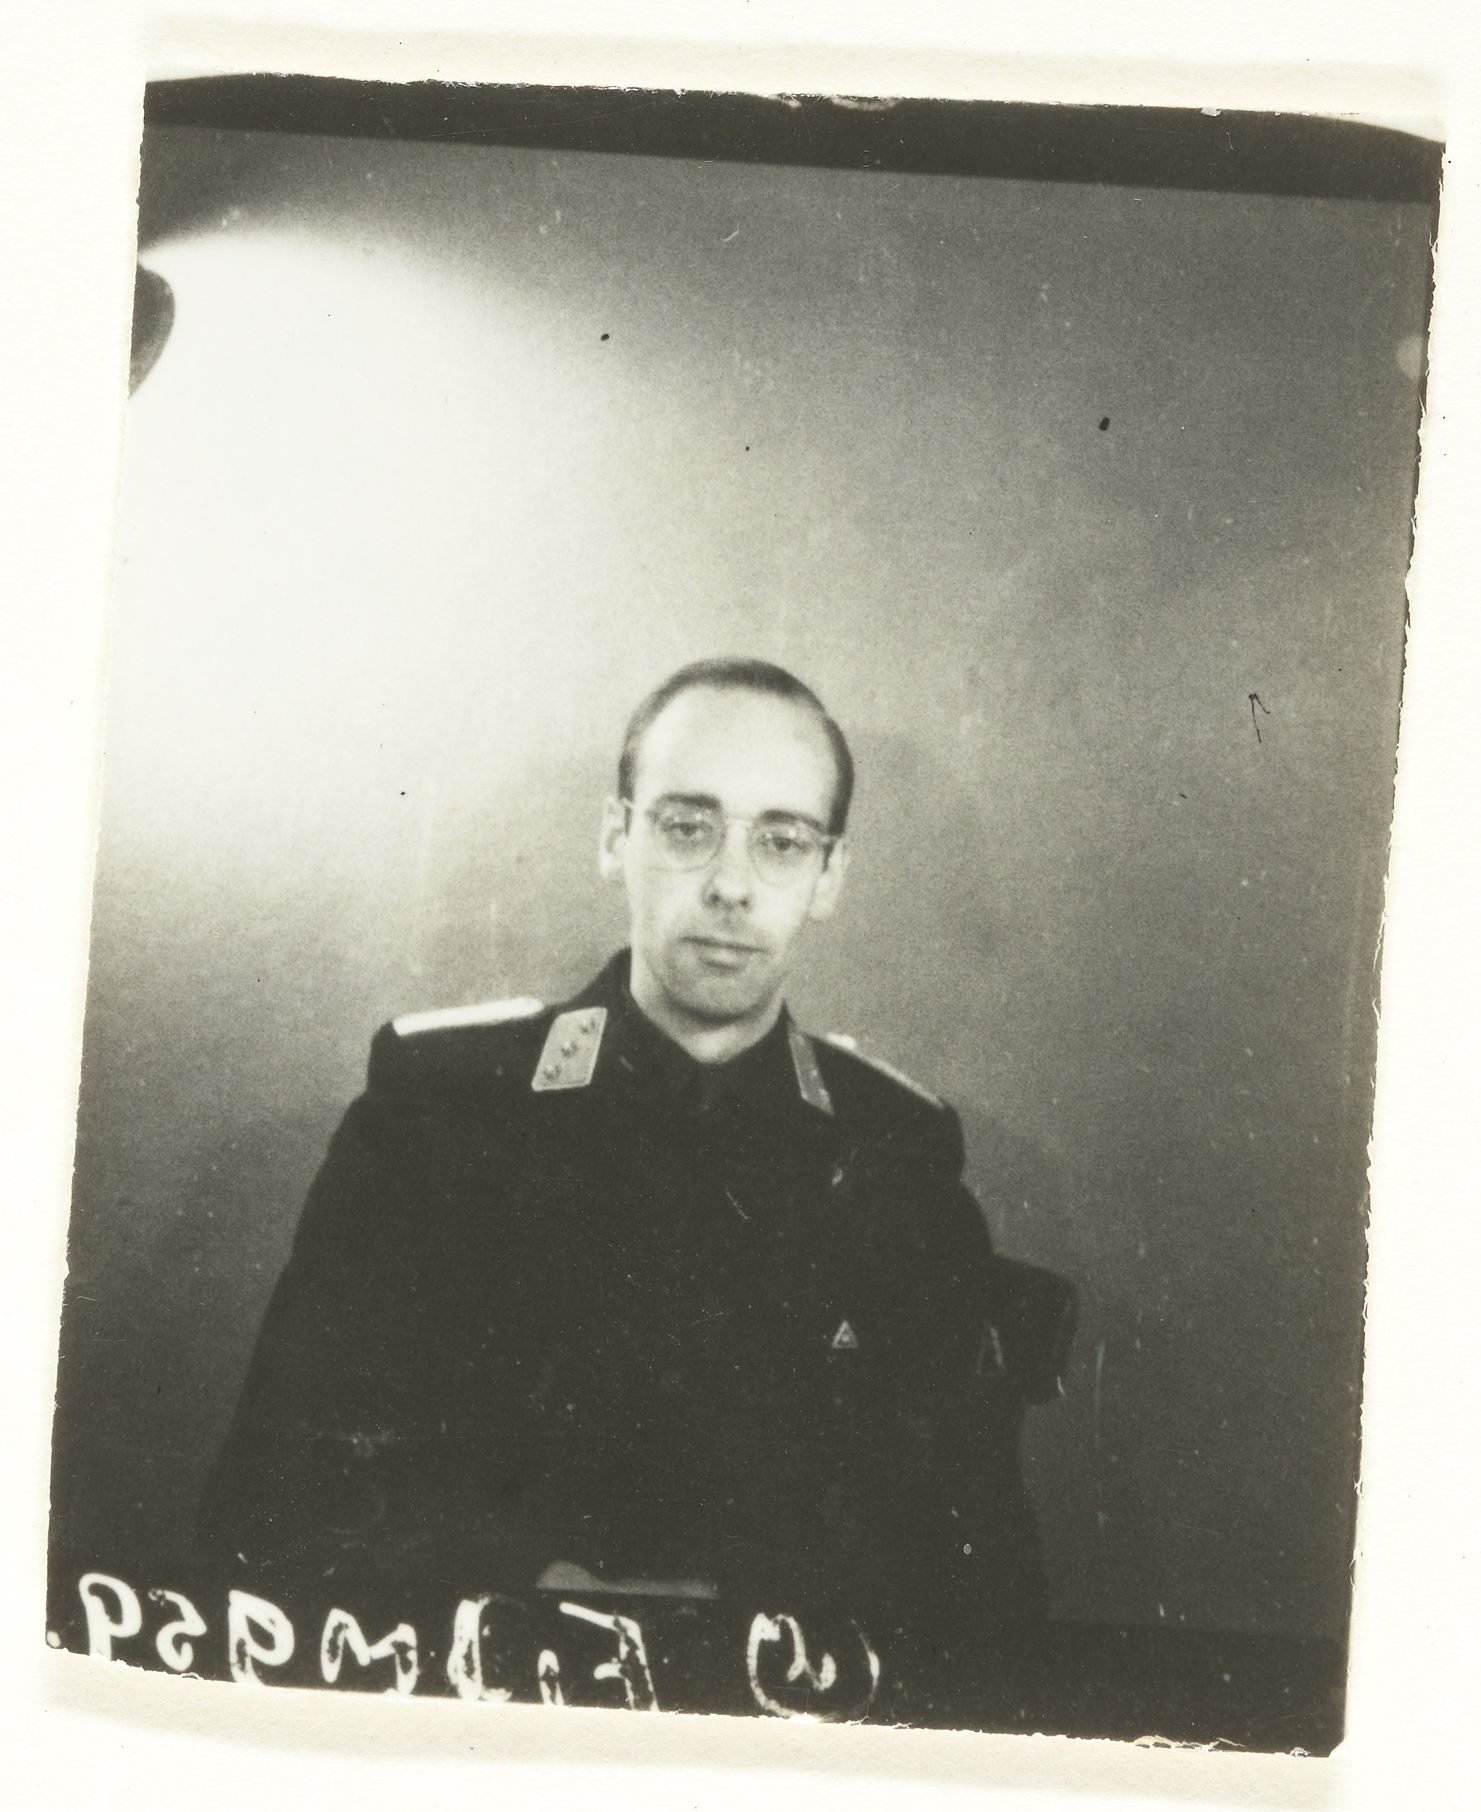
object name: contact print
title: Portret van een lid van de WA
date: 1940-1944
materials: photographic support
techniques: gelatin silver print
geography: netherlands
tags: anonymous historical person portrayed, netherlands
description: Portret van een lid van de WA. Op zijn kraag een distinctief met drie sterren, mogelijk gaat het om een Hopman. Hij draagt een bril en is blootshoofds.